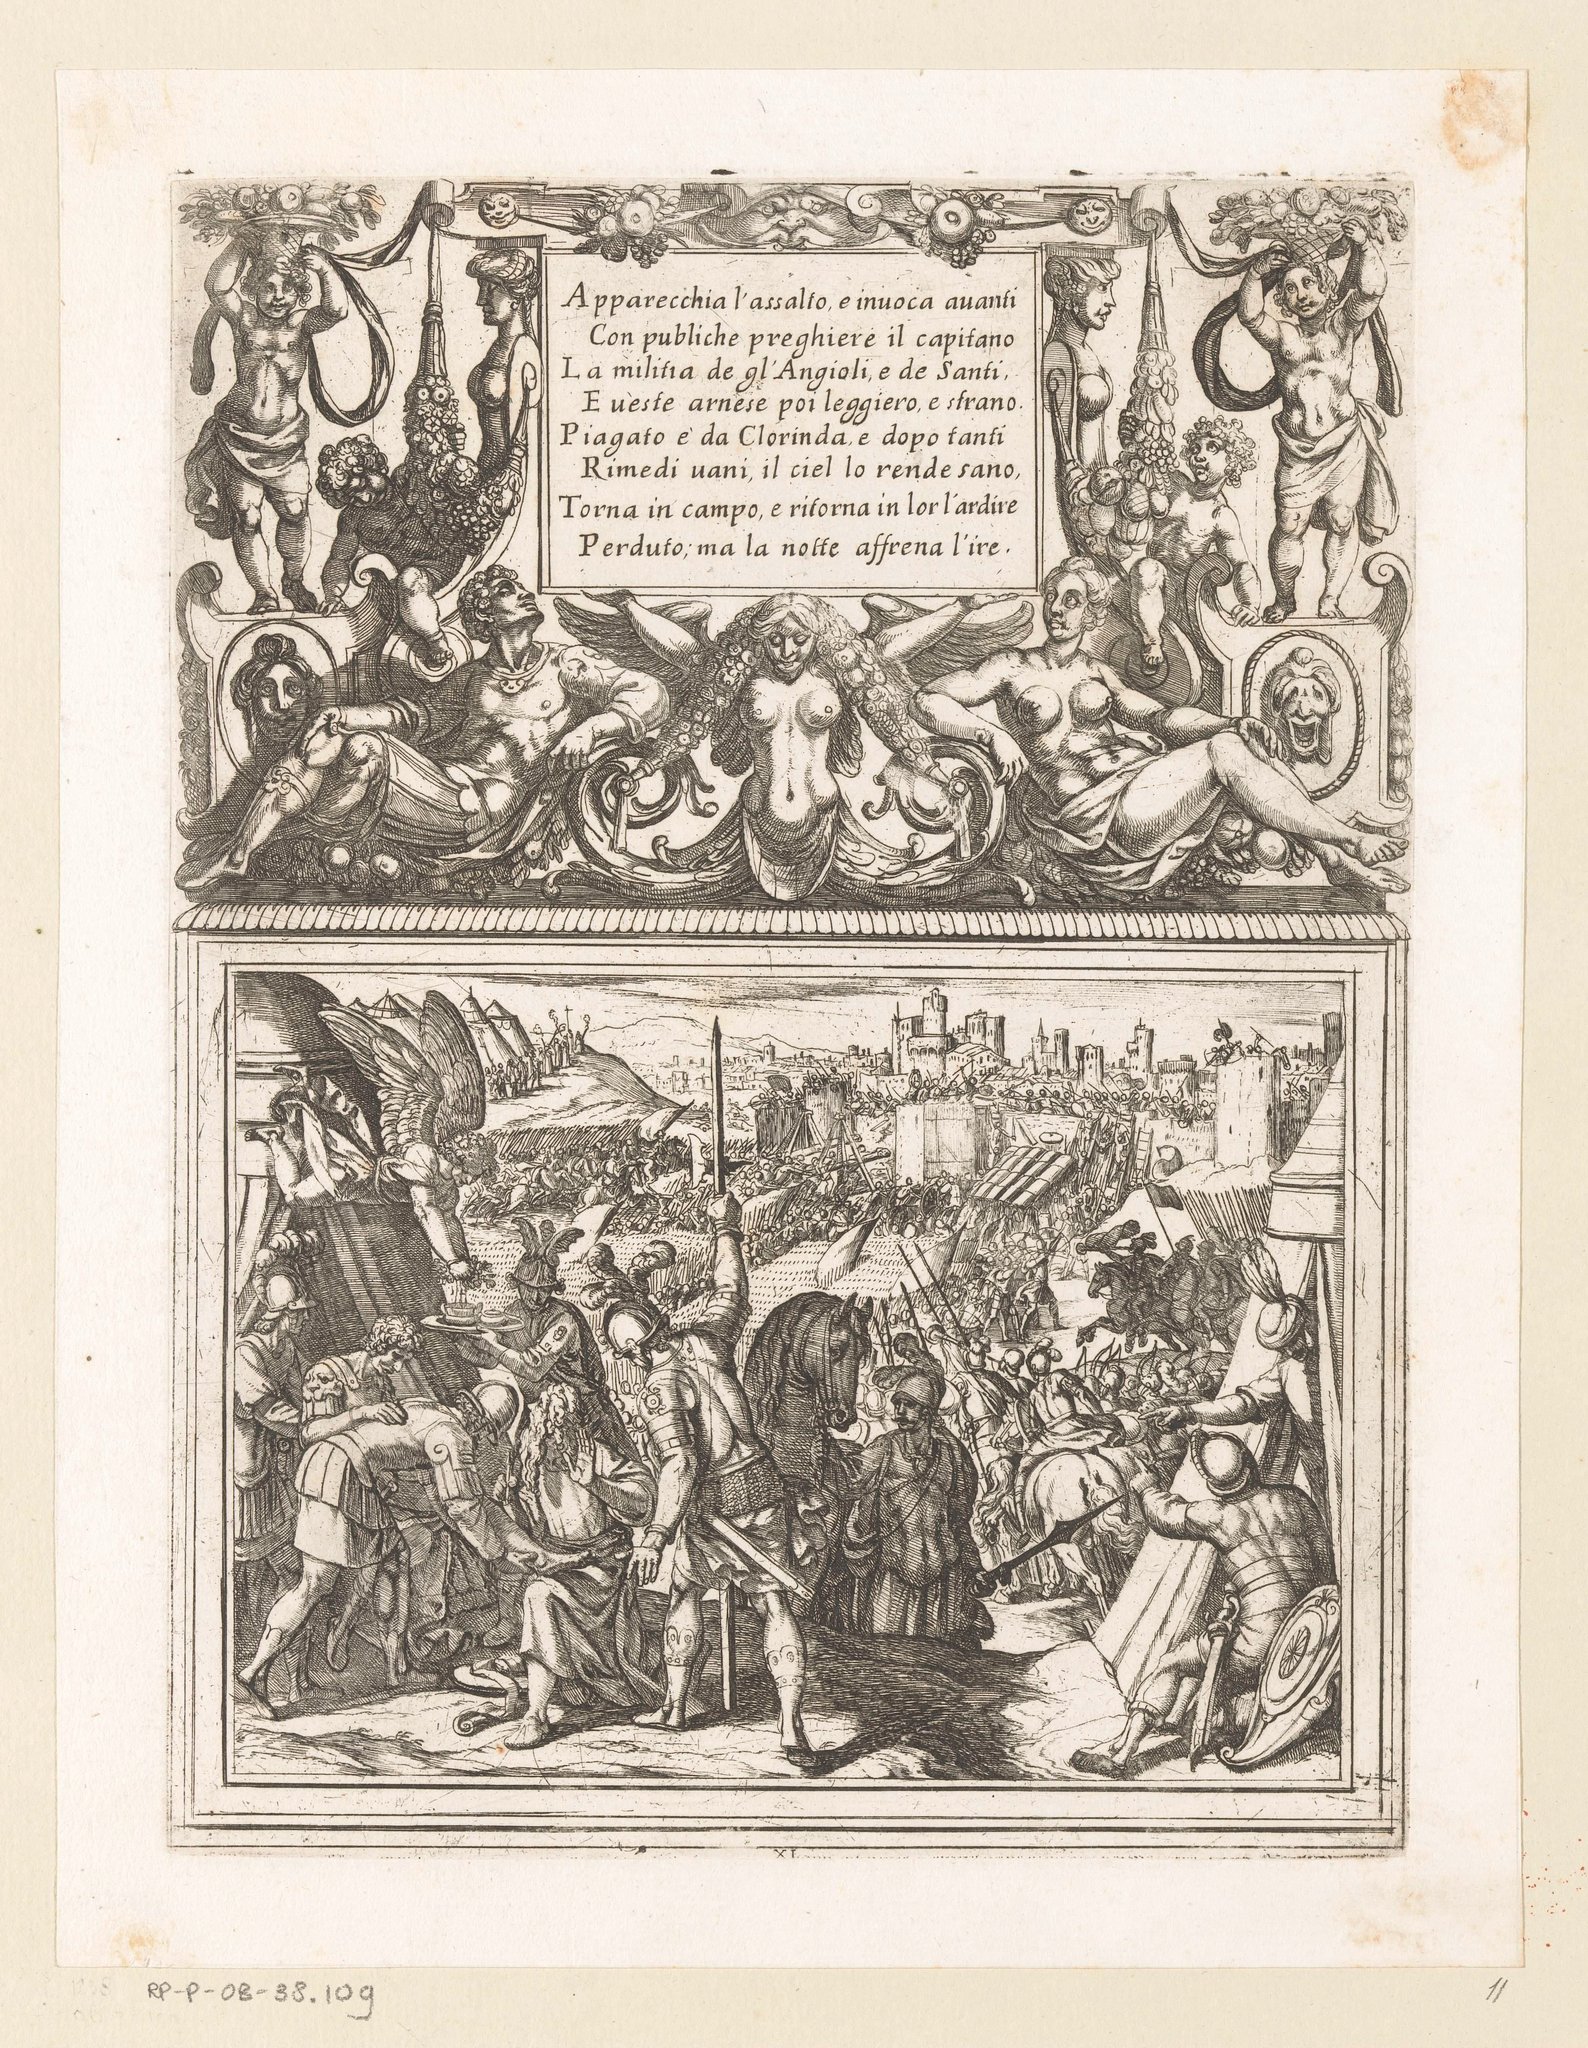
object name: print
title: Jeruzalem verlost (deel 3)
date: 1565-1630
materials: paper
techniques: etching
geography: italy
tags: ornaments ~ art, battle, militant proselytizing: religious war, crusade, etc., ornament ~ cartouche, (scenes from) specific works of literature: tasso, gerusalemme liberata, knight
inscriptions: collector's mark: Lugt 240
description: Deze prent maakt deel uit van een reeks van twintig prenten met ornamentele sierlijsten met daarin voorstellingen van scènes uit Tasso's 'Jeruzalem verlost', een episch gedicht geschreven door de Italiaanse dichter Torquato Tasso en voor het eerst gepubliceerd in 1581. Het verhaal vertelt grotendeels in fictie over de Eerste Kruistocht waarin de christenen, geleid door Godfried van Bouillon, de strijd aangaan met de moslims om het Beleg van Jeruzalem.